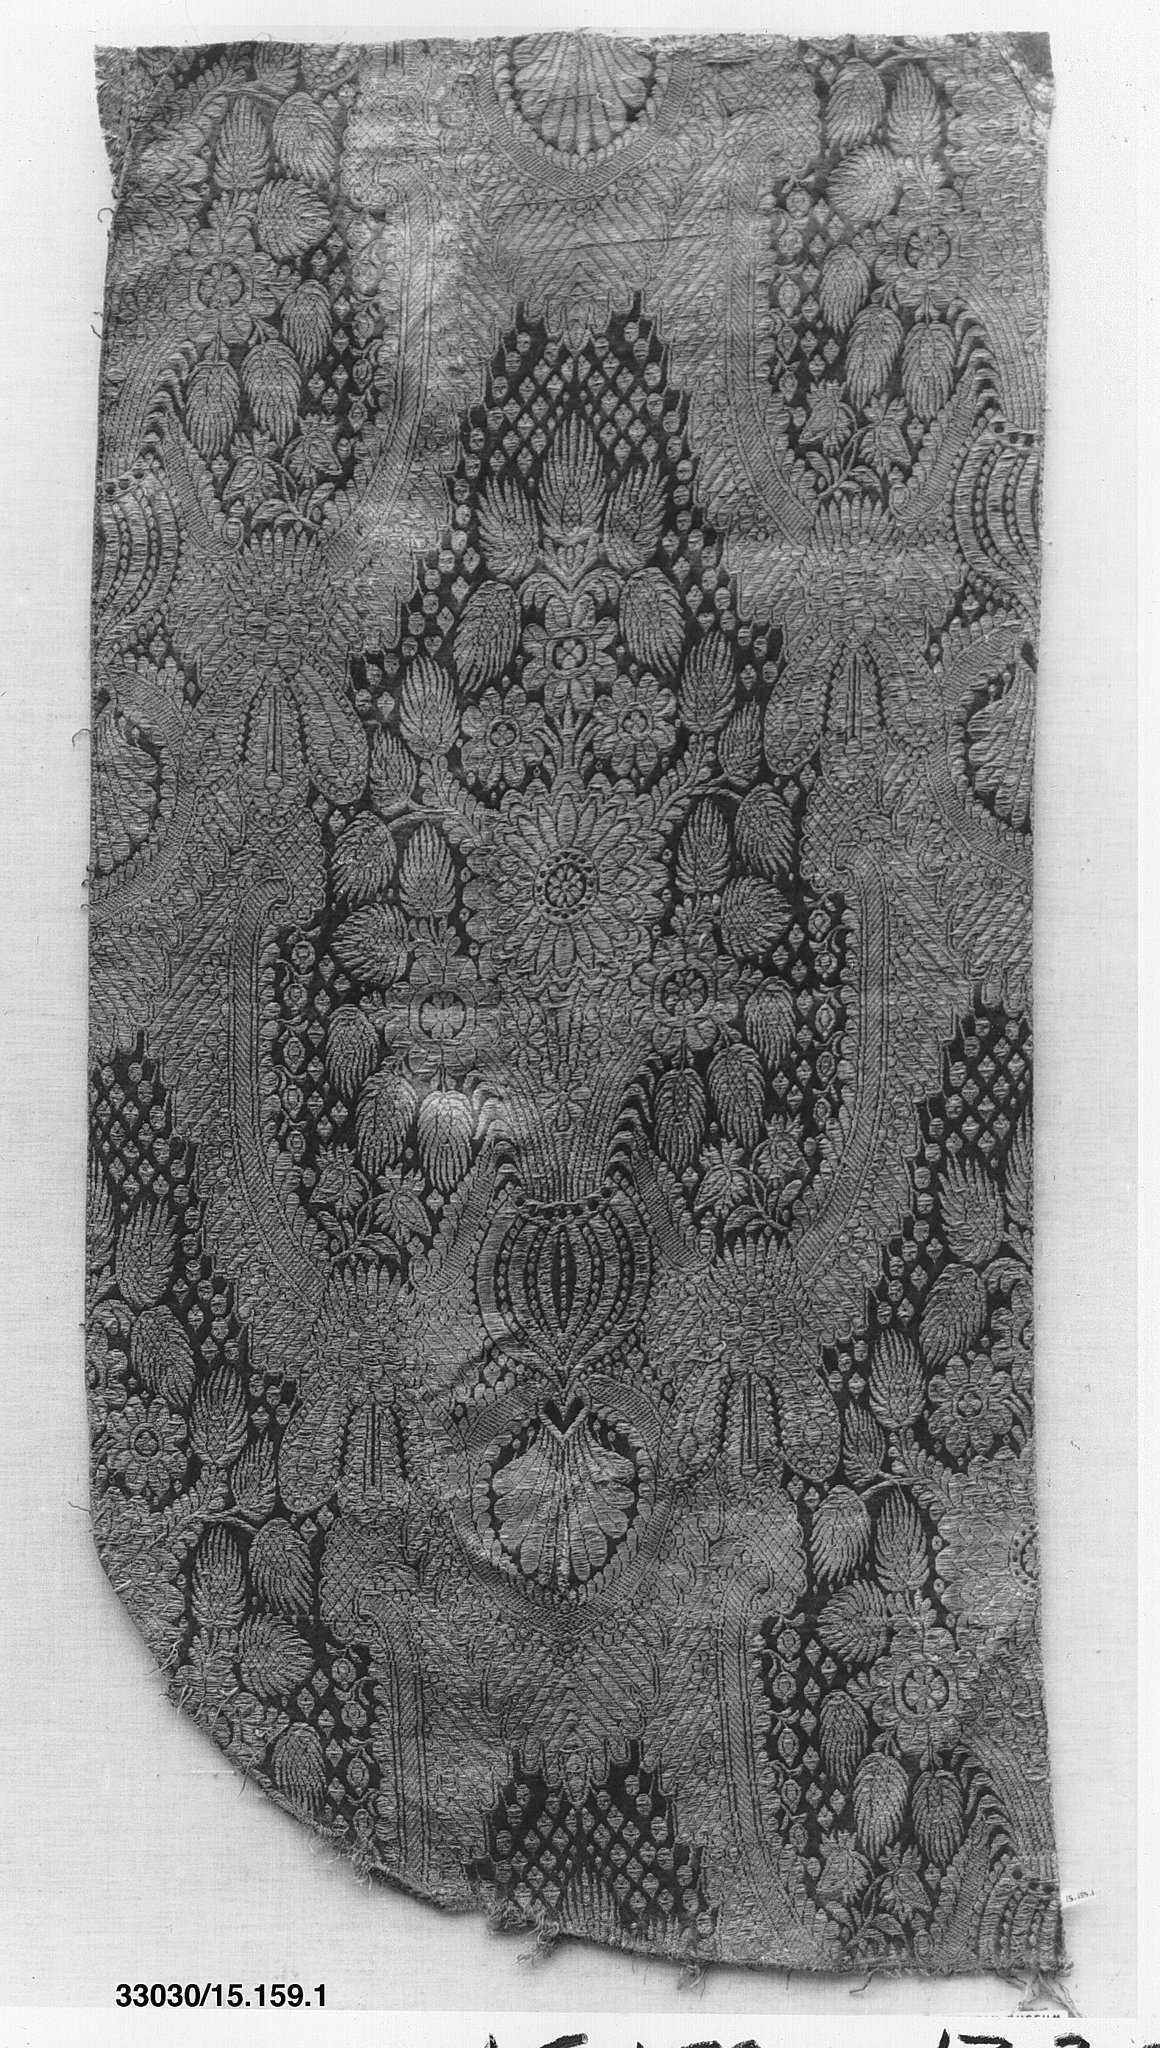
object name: piece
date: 1701-1800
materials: metal thread, silk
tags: flowers,leaves